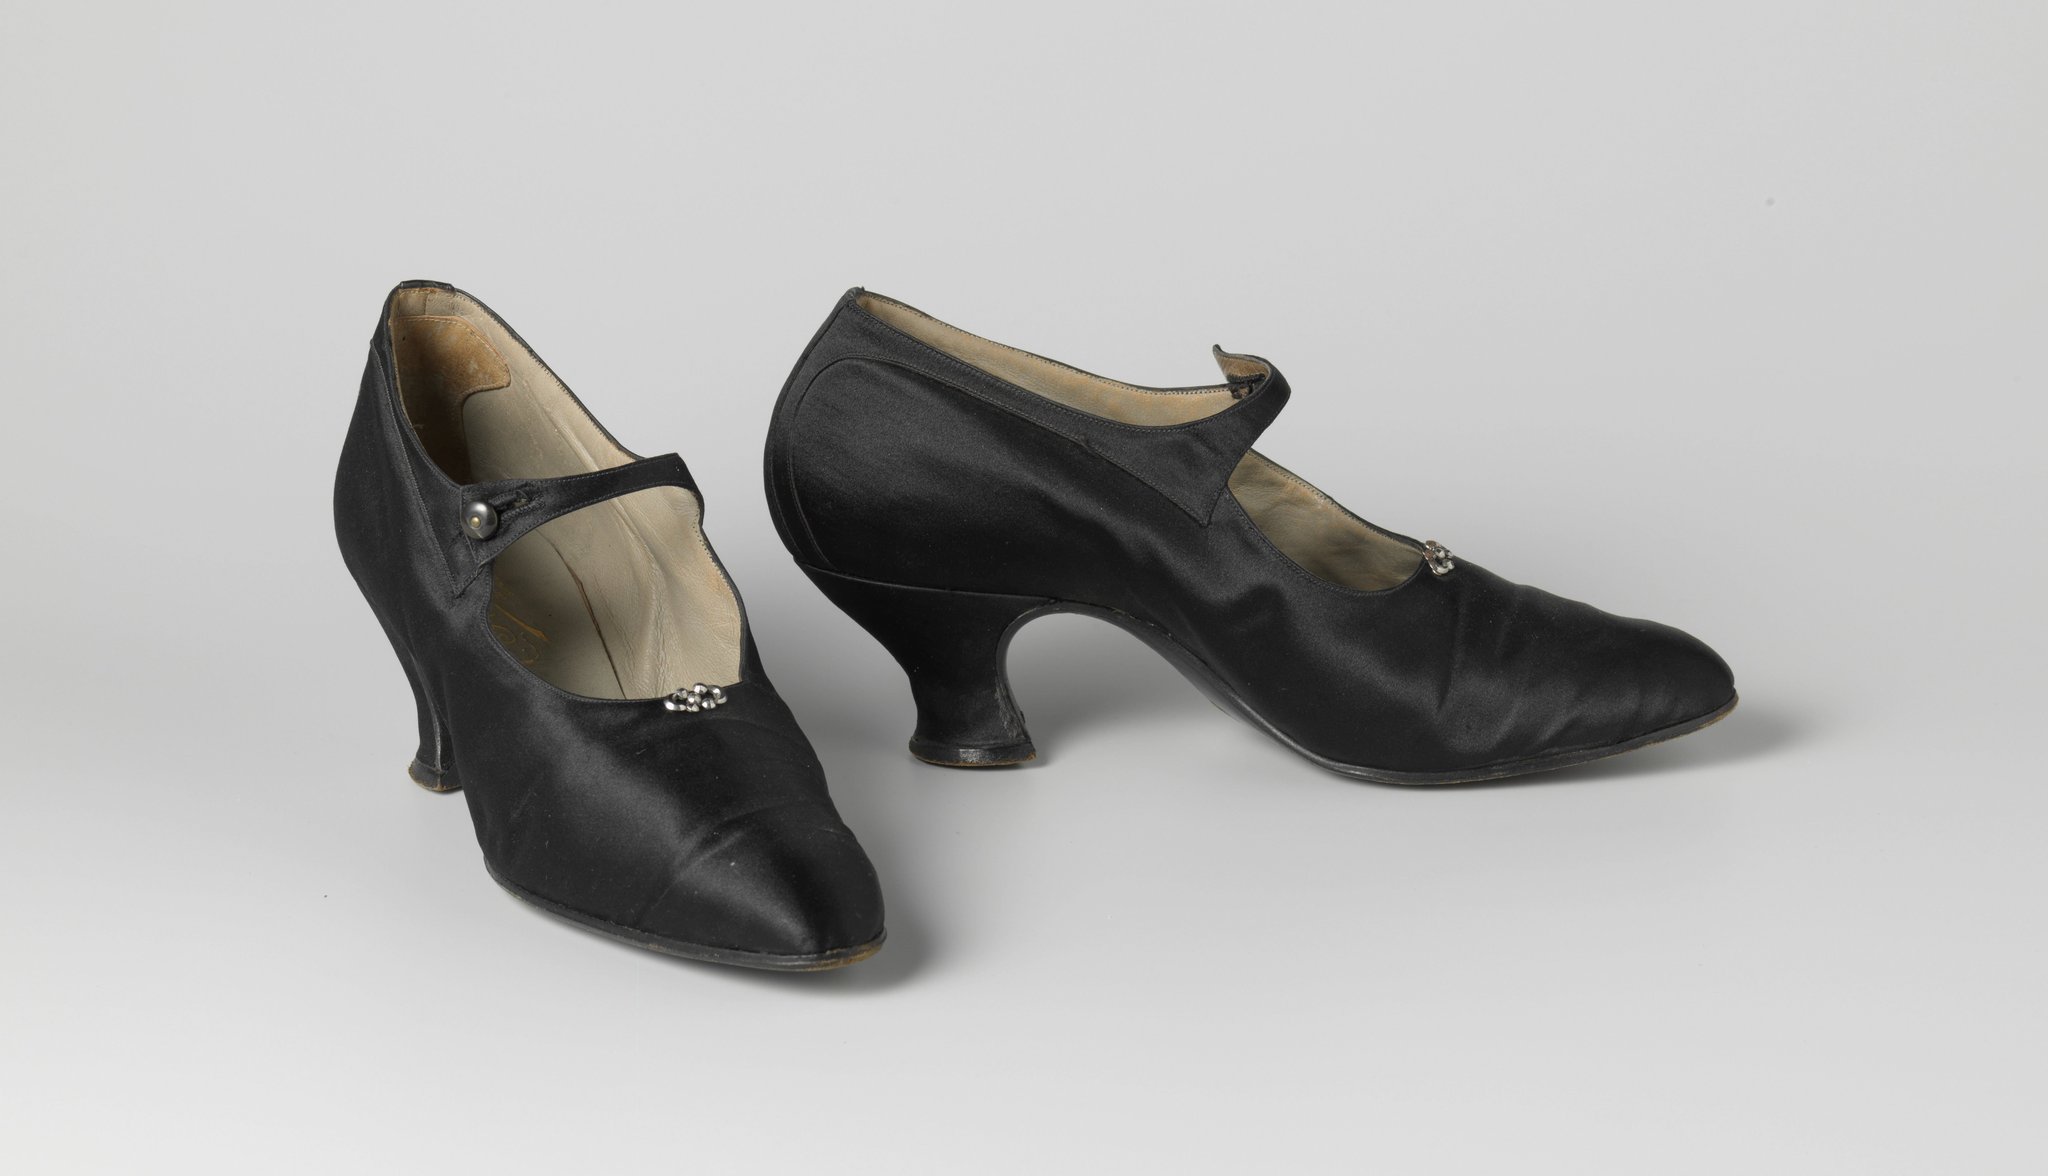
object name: shoe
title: Schoen van zwart satijn met 'pompadour' hak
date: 1915-1920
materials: leather, metal, plastic, textile, silk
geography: haarlem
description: Linkerschoen van zwart satijn. Model: ronde neus, blad uit een stuk met bij de hiel twee losse bladen uitlopend in wreefband met kunsstof knoop. Met 'pompadour' hak, zijkant en achterkant van de hak zijn bekleed met zwart satijn. De hak heeft een zwarte rand leer van het achterflapje. Leren achterflapje met 8 spijkers aan de hak vastgeslagen en zwarte leren zool. Schoen gevoerd met grijs kleurig leer. In de hiel een stuk T-vormig bruin geruwd leer. Versiering: zilverkleurig metalen ornament middenvoor.